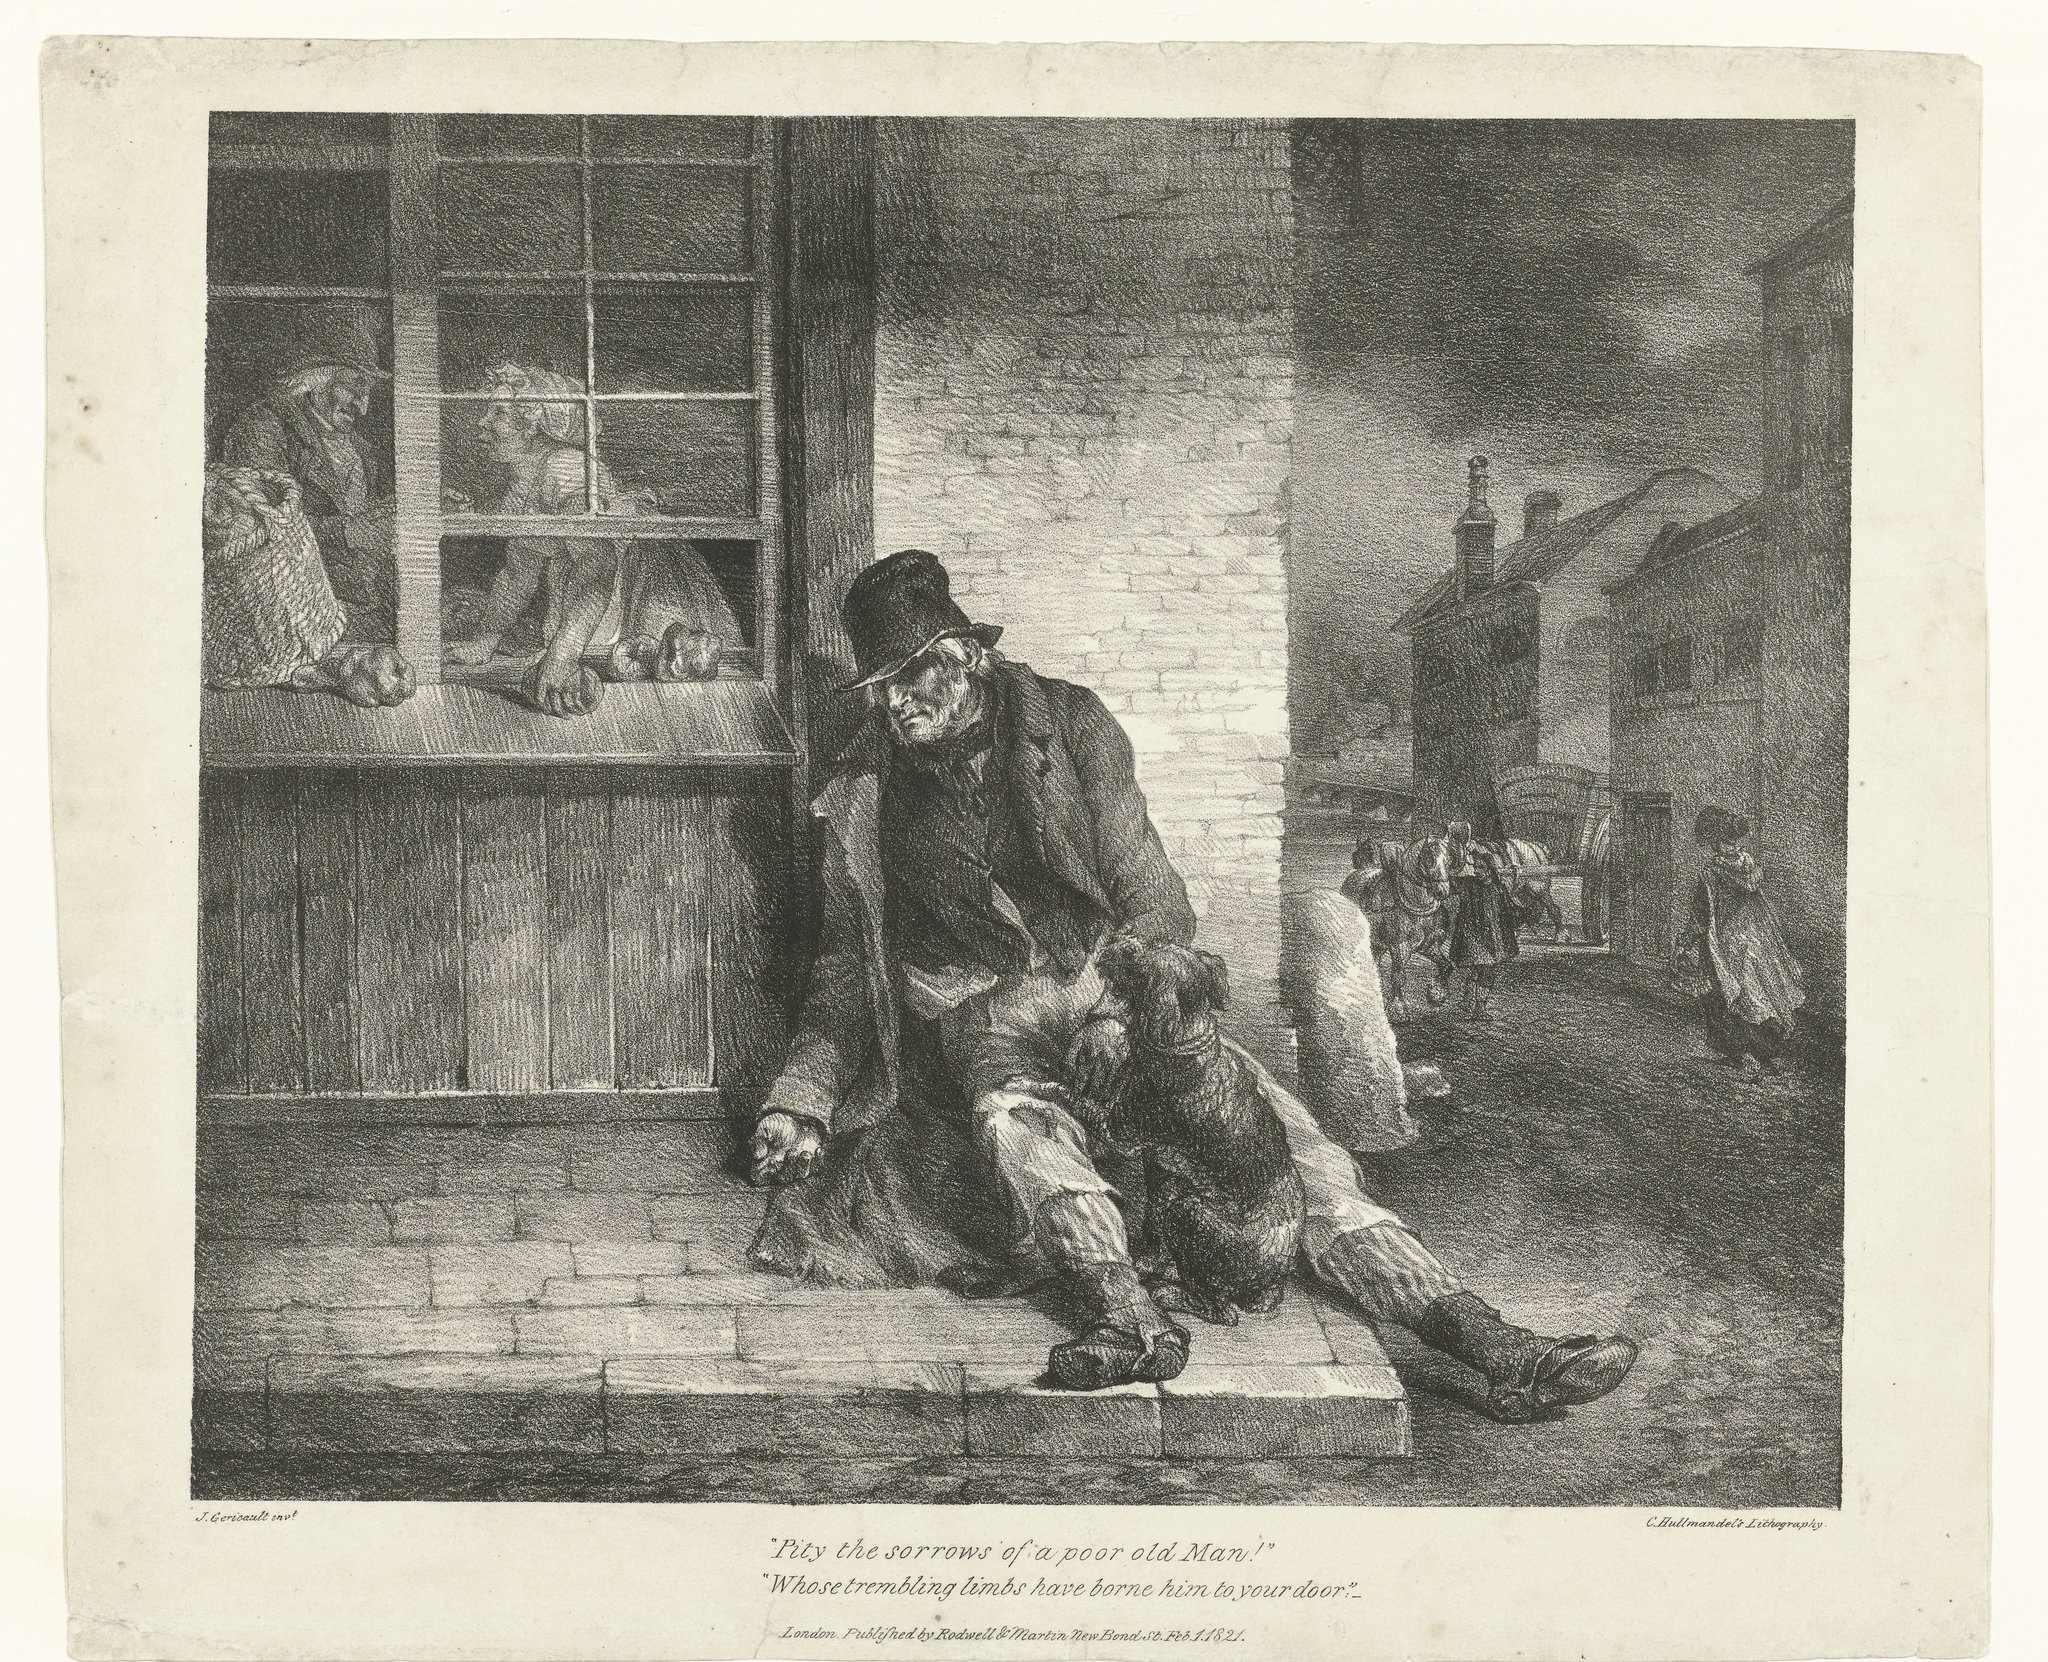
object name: print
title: Various subjects drawn from life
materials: paper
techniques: lithograph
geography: london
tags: beggar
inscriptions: collector's mark: Lugt 2228, collector's mark: Lugt 2760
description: Een bedelaar zittend op de hoek van een straat naast een winkelruit waarchter een man en een vrouw te zien zijn. Onder de voorstelling twee regels uit het gedichtje The Beggar's Petition van Thomas Moss.